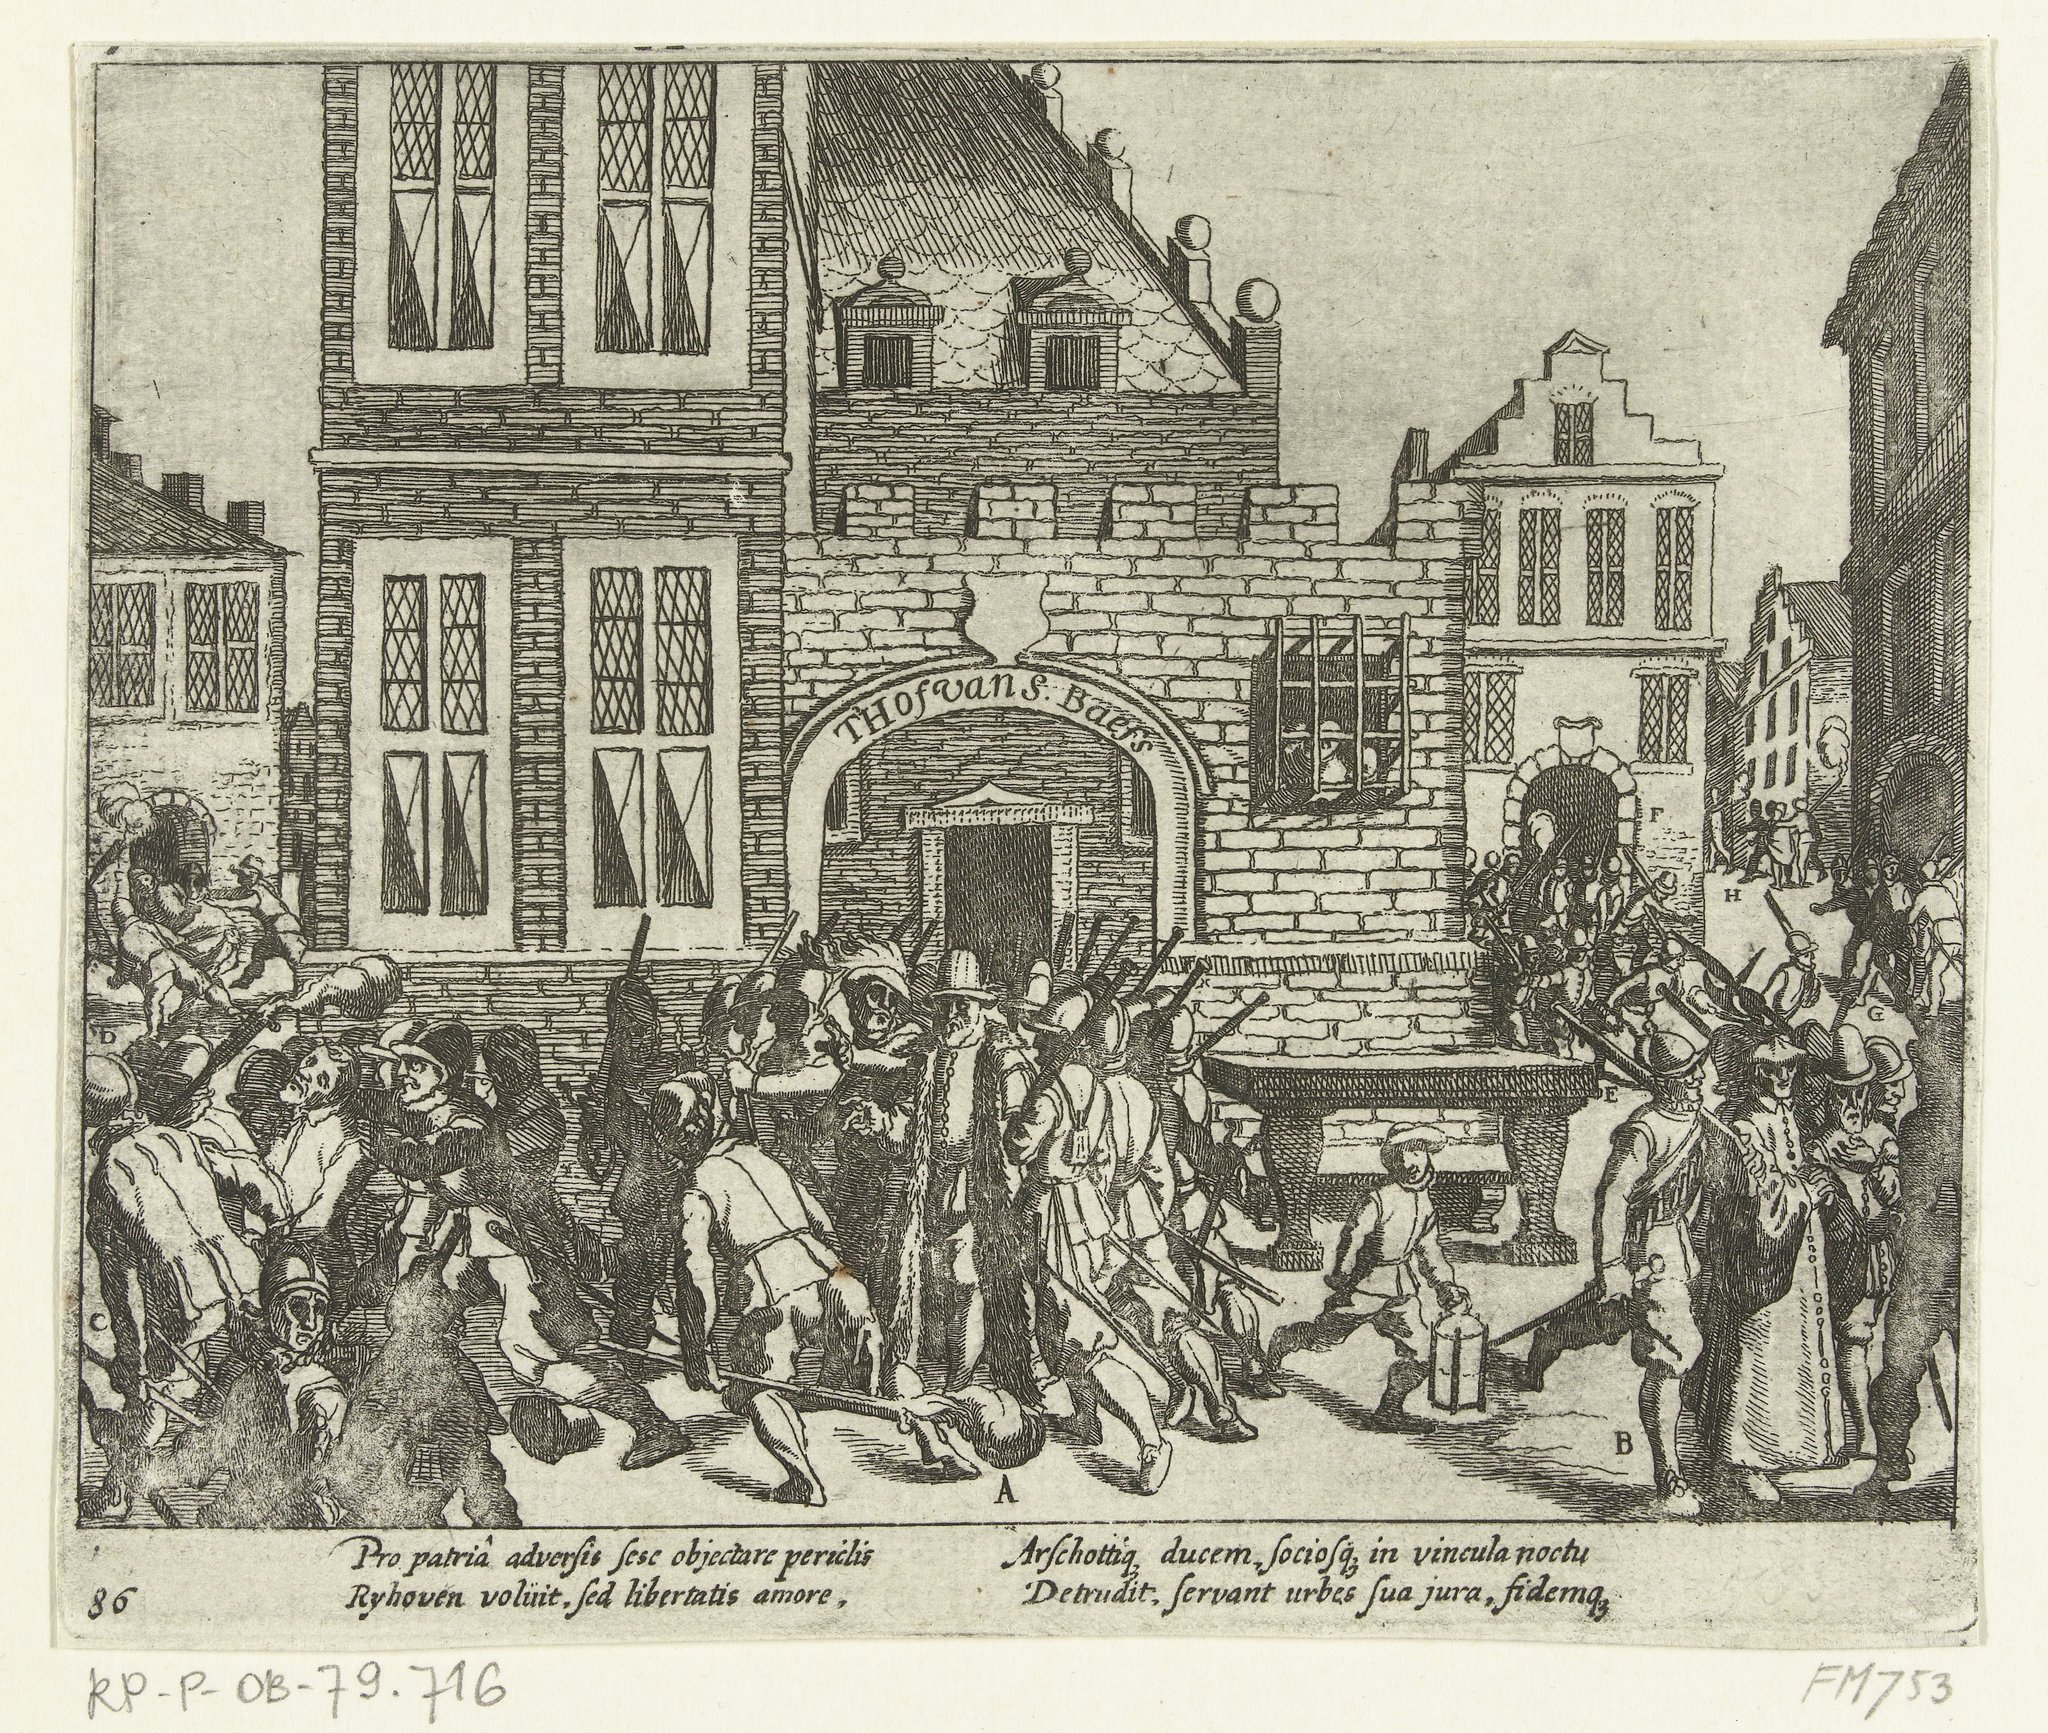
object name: print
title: Hertog van Aarschot te Gent gevangen genomen, 1577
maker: simon frisius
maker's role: print maker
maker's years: 1570-1628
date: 1613-1615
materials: paper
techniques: etching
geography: netherlands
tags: venice, earl, imprisonment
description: De gevangenneming van de hertog van Aarschot en andere edelen in het Hof van S. Baeffs te Gent, 28 oktober 1577. Met onderschrift van 4 regels in het Latijn. Genummerd: 86. Bedrukt op achterzijde met tekst in het Latijn.